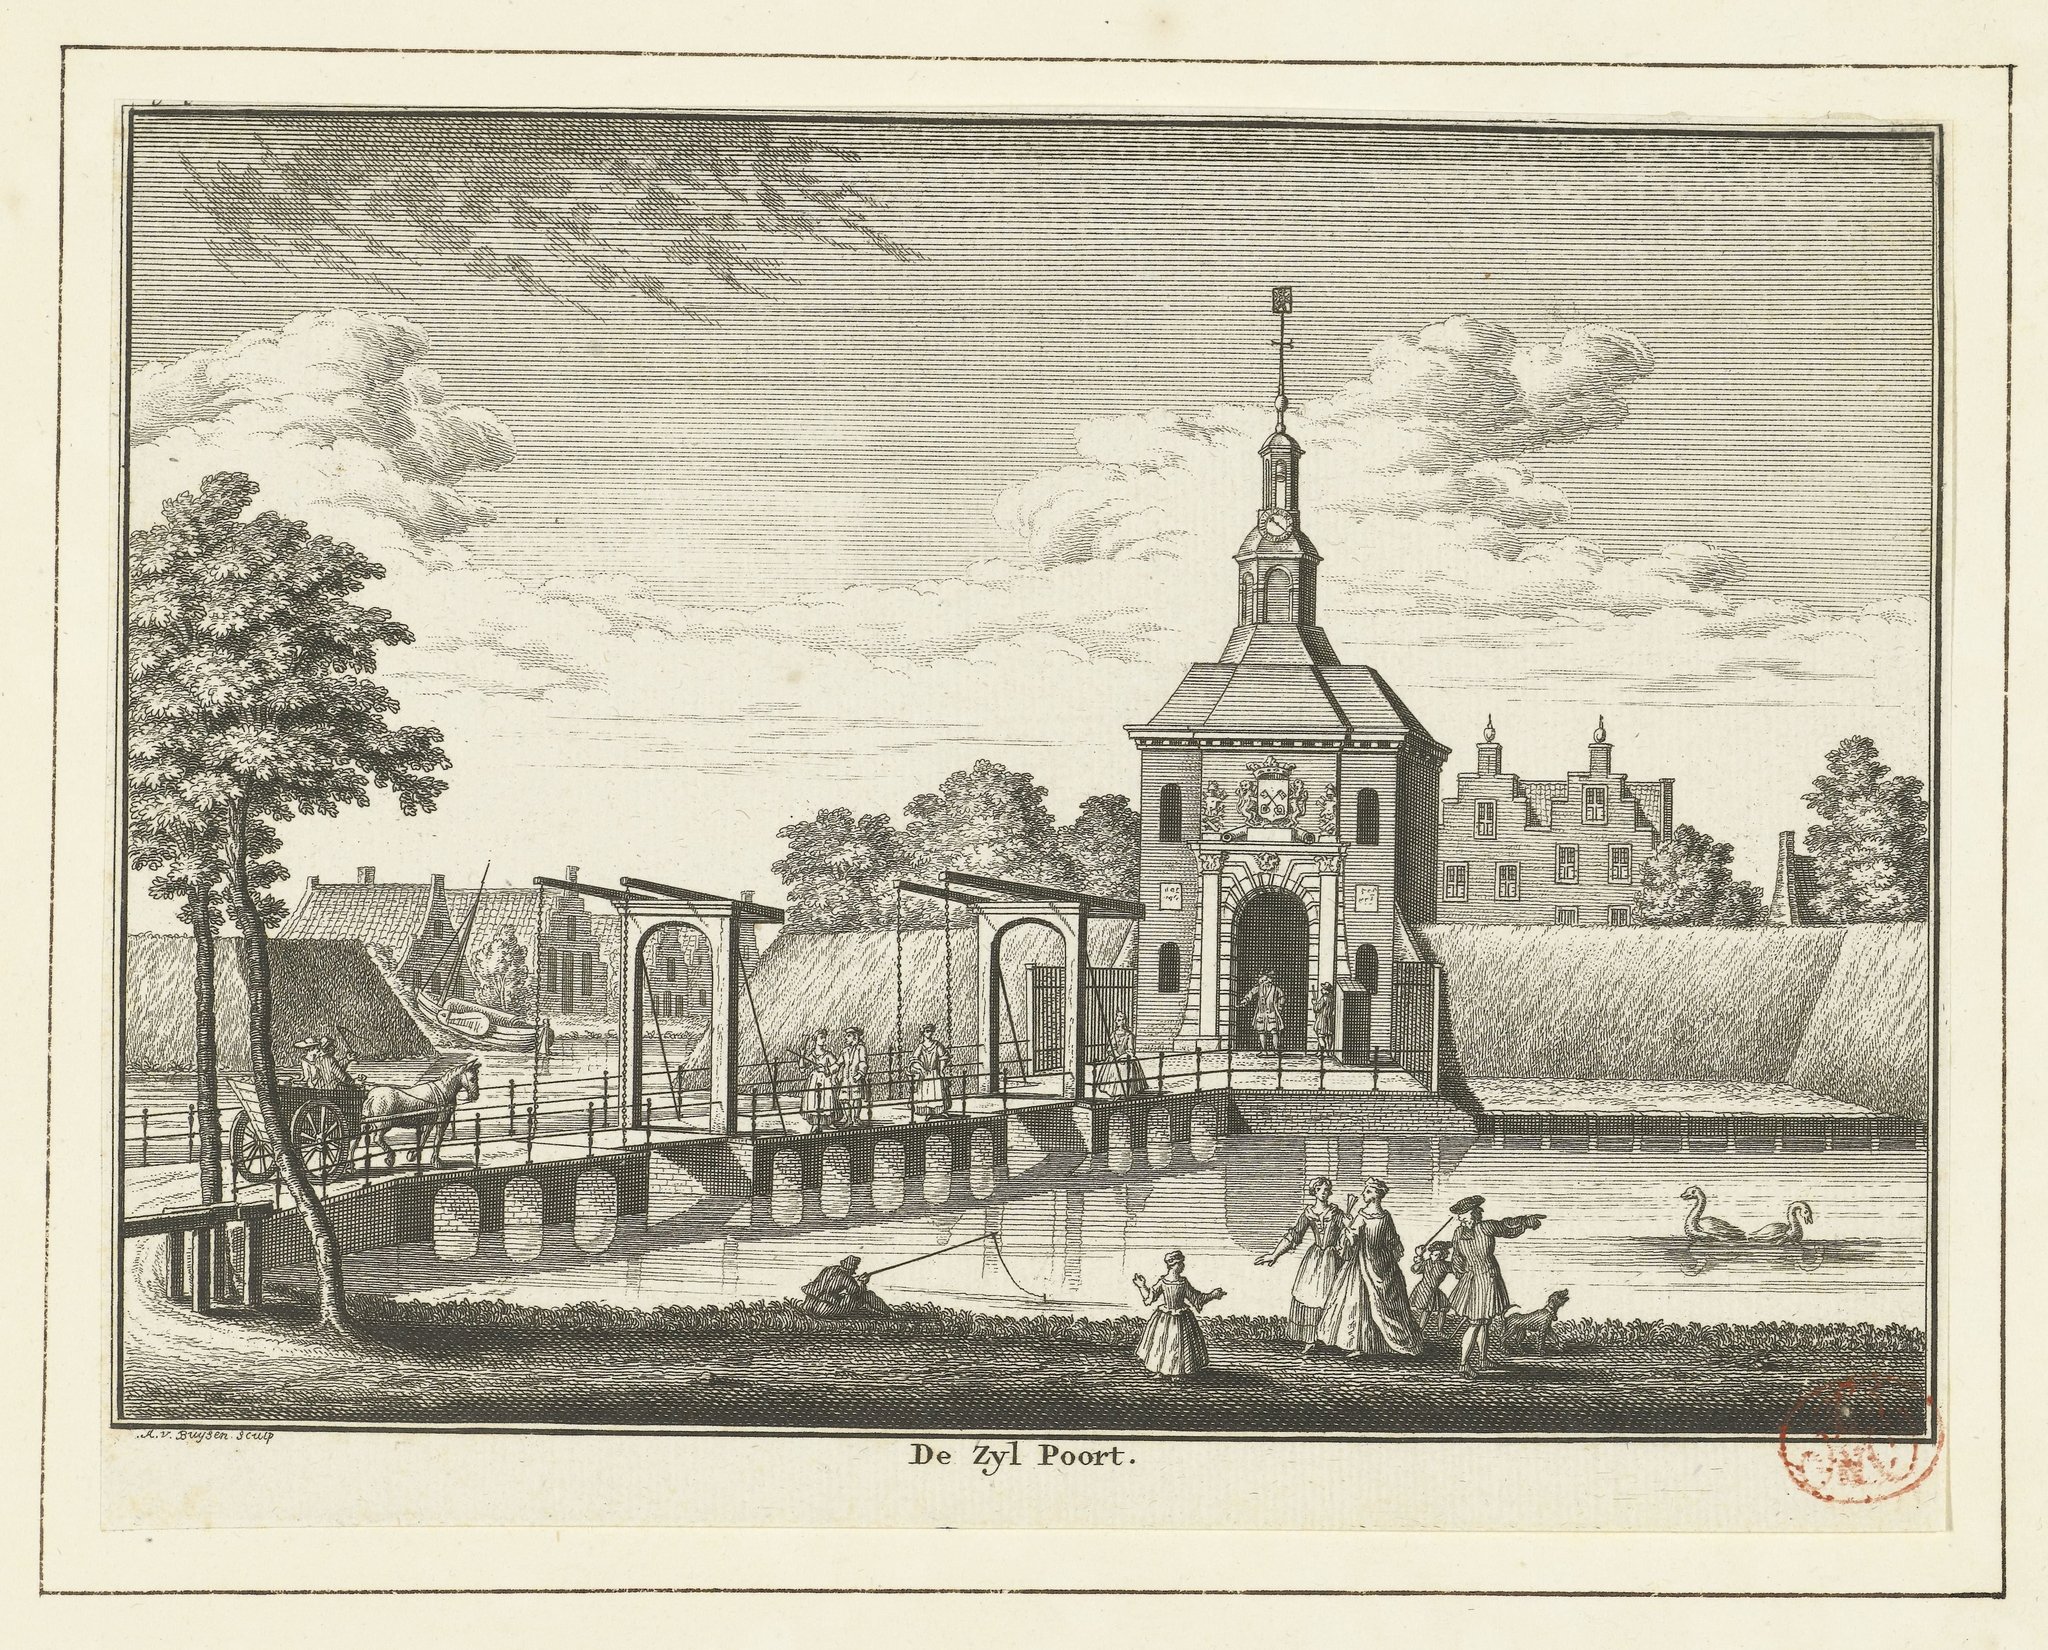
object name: book illustration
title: De Zyl Poort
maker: andries van buysen (sr.)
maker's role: print maker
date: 1734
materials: paper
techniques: engraving, etching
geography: amsterdam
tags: bridge, city-gate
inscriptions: collector's mark: Lugt 2228, collector's mark: Lugt 195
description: Prent ook gebruikt in: De vermakelyke Leidsche buiten-cingels, aangenaame dorpen en landstreken, rondom die stad gelegen (…) versiert met alle de stadts-poorten. Leiden: Quirinum Visscher, Amsterdam: Arent van Huyssteen, 1734.